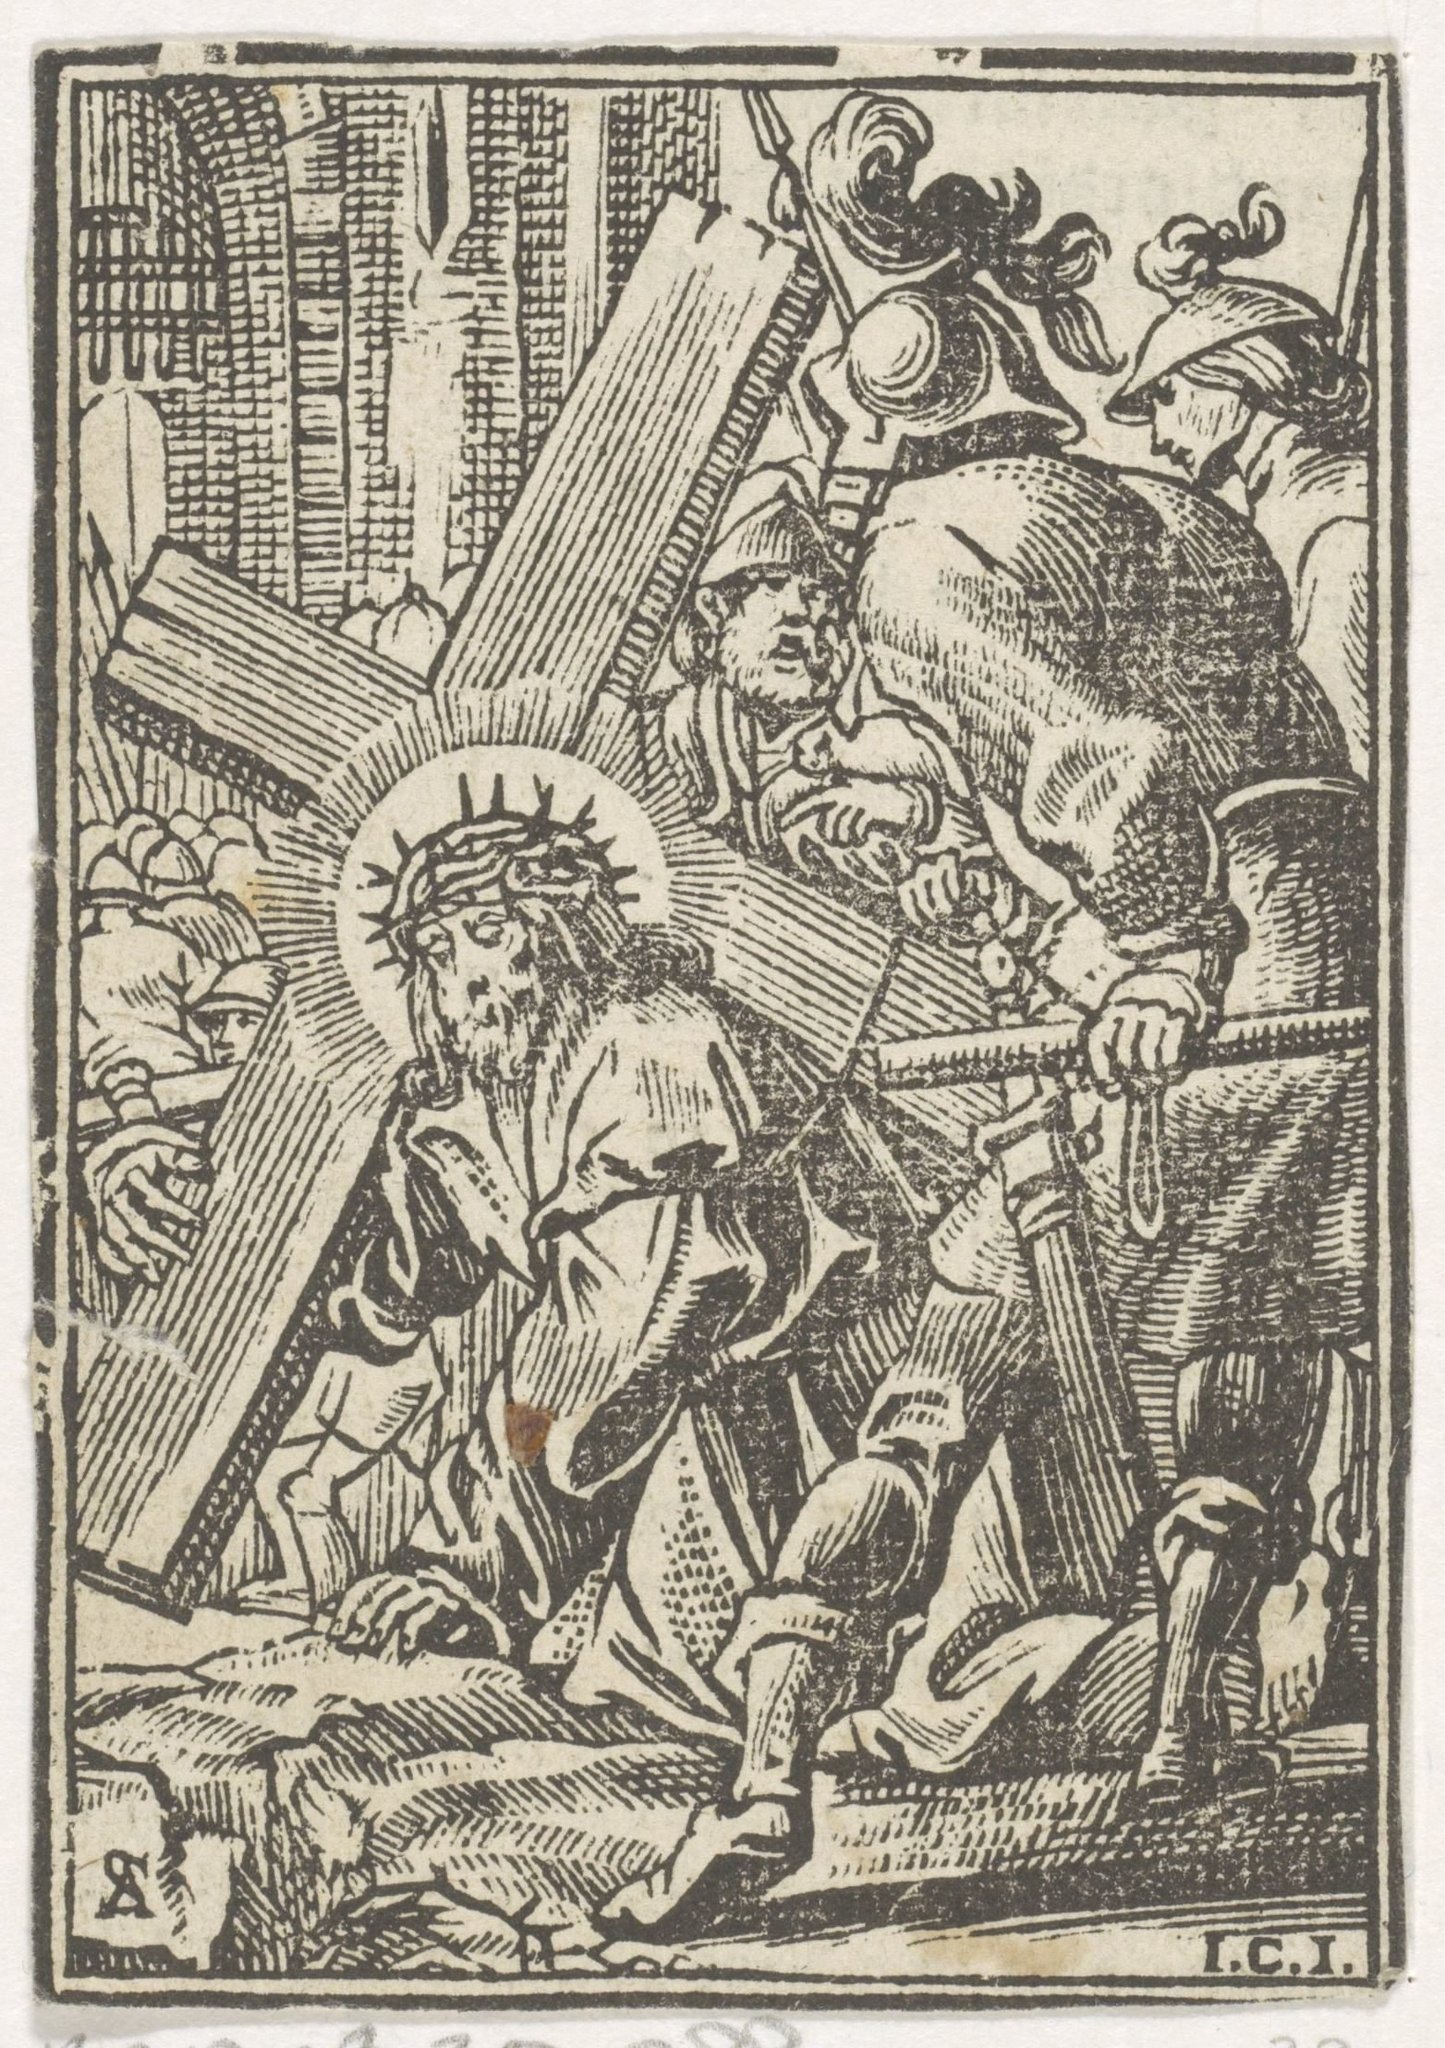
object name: book illustration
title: Christus bezwijkt voor tweede keer tijdens de kruisdraging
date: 1649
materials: paper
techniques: letterpress printing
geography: antwerp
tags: second fall ~ christ carrying the cross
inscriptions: collector's mark: Lugt 240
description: Prent uit: Andries, Judocus. Perpetua crux sive passio Jesu Christi. Antwerpen: Cornelis Woons, 1649.